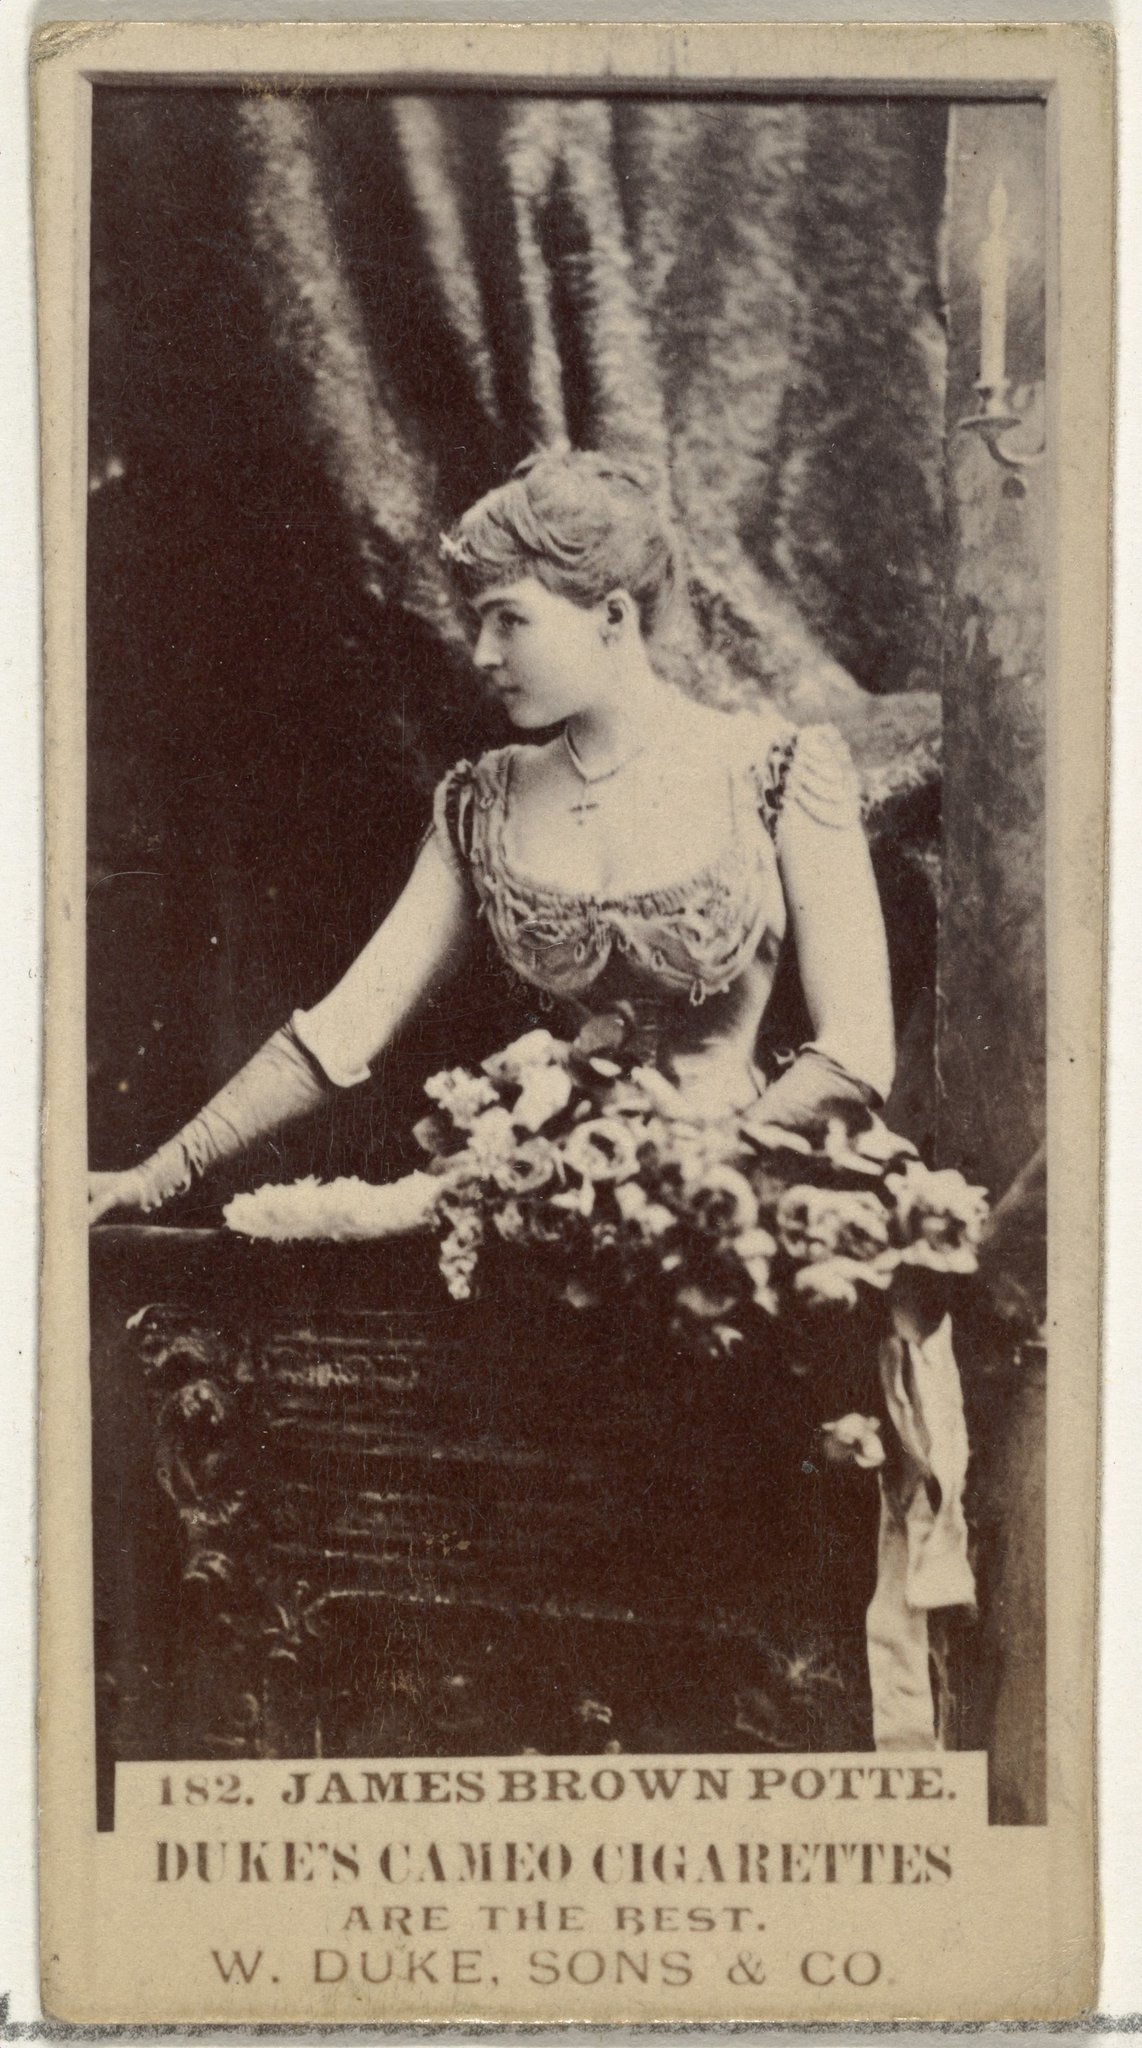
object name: photograph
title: Card Number 182, Mrs. James Brown Potter, from the Actors and Actresses series (N145-5) issued by Duke Sons & Co. to promote Cameo Cigarettes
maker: w. duke, sons & co.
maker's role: publisher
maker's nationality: american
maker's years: 1870-1920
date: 1880-1889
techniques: albumen silver print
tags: women,actresses